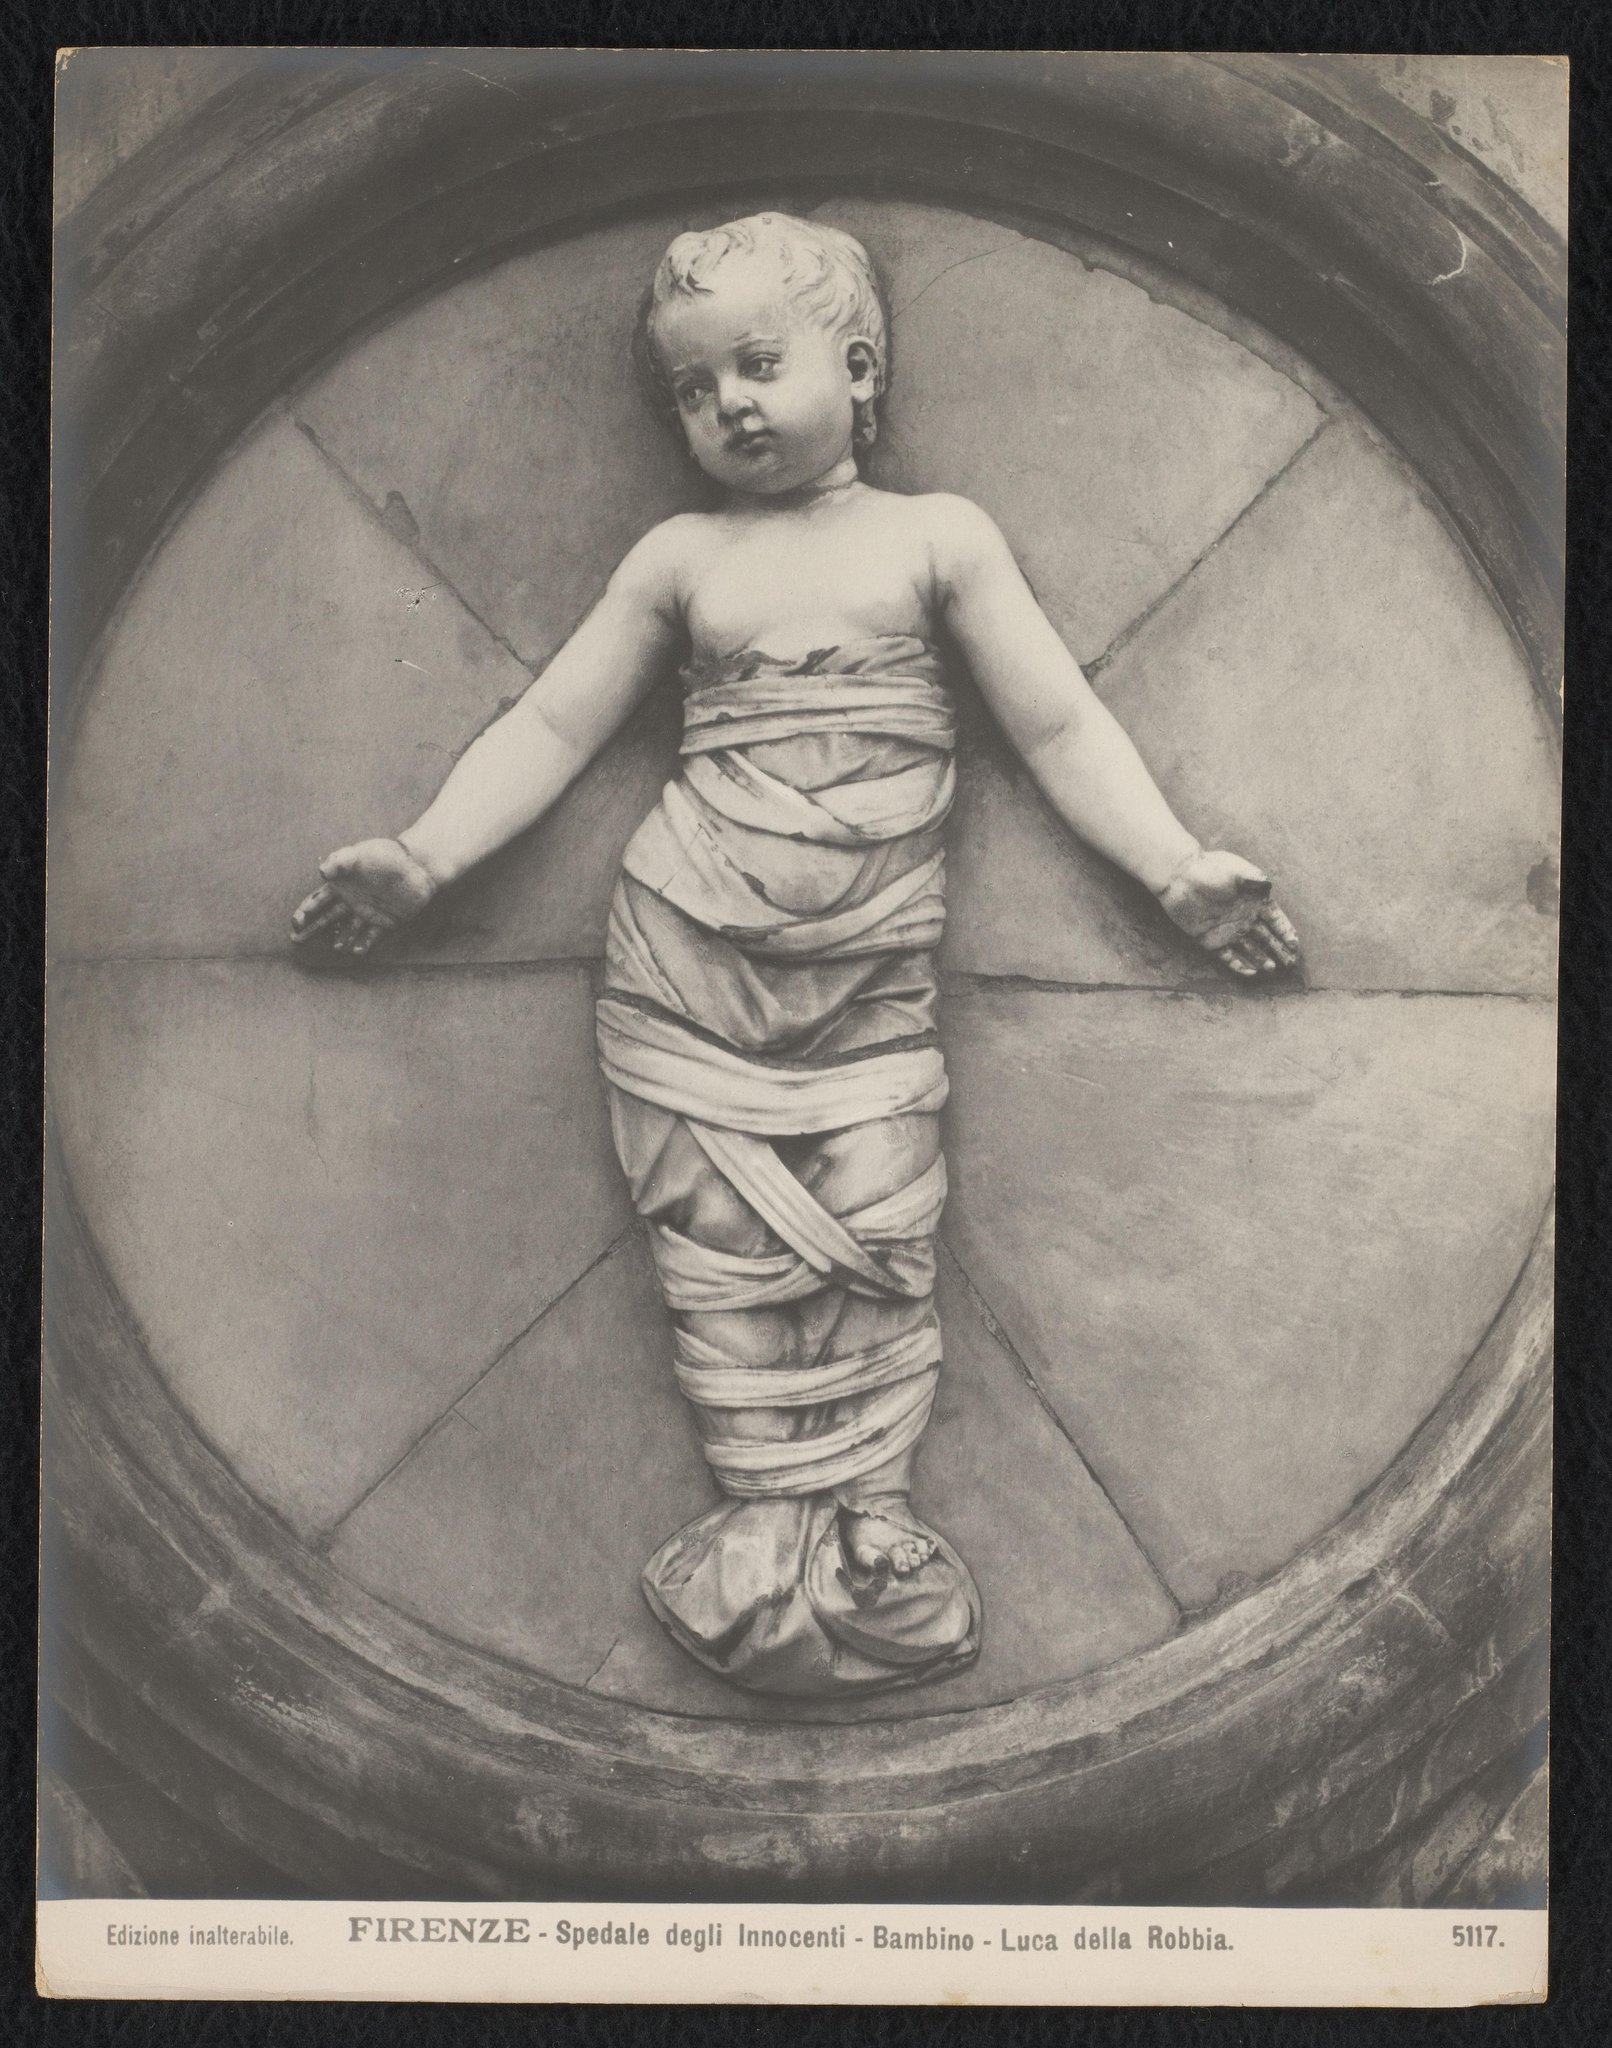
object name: photograph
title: Firenze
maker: Anonymous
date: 1900-1920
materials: paper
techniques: gelatin silver print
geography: berlin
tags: art (+ relief ~ sculpture)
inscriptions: inscription: ‘Edizione inalterabile.’, collector's mark: ‘RIJKS SCHOOL VOOR KUNSTNIJVERHEID/ GROEP’, number: ‘5117.’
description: Deze foto maakt deel uit van een omslag.